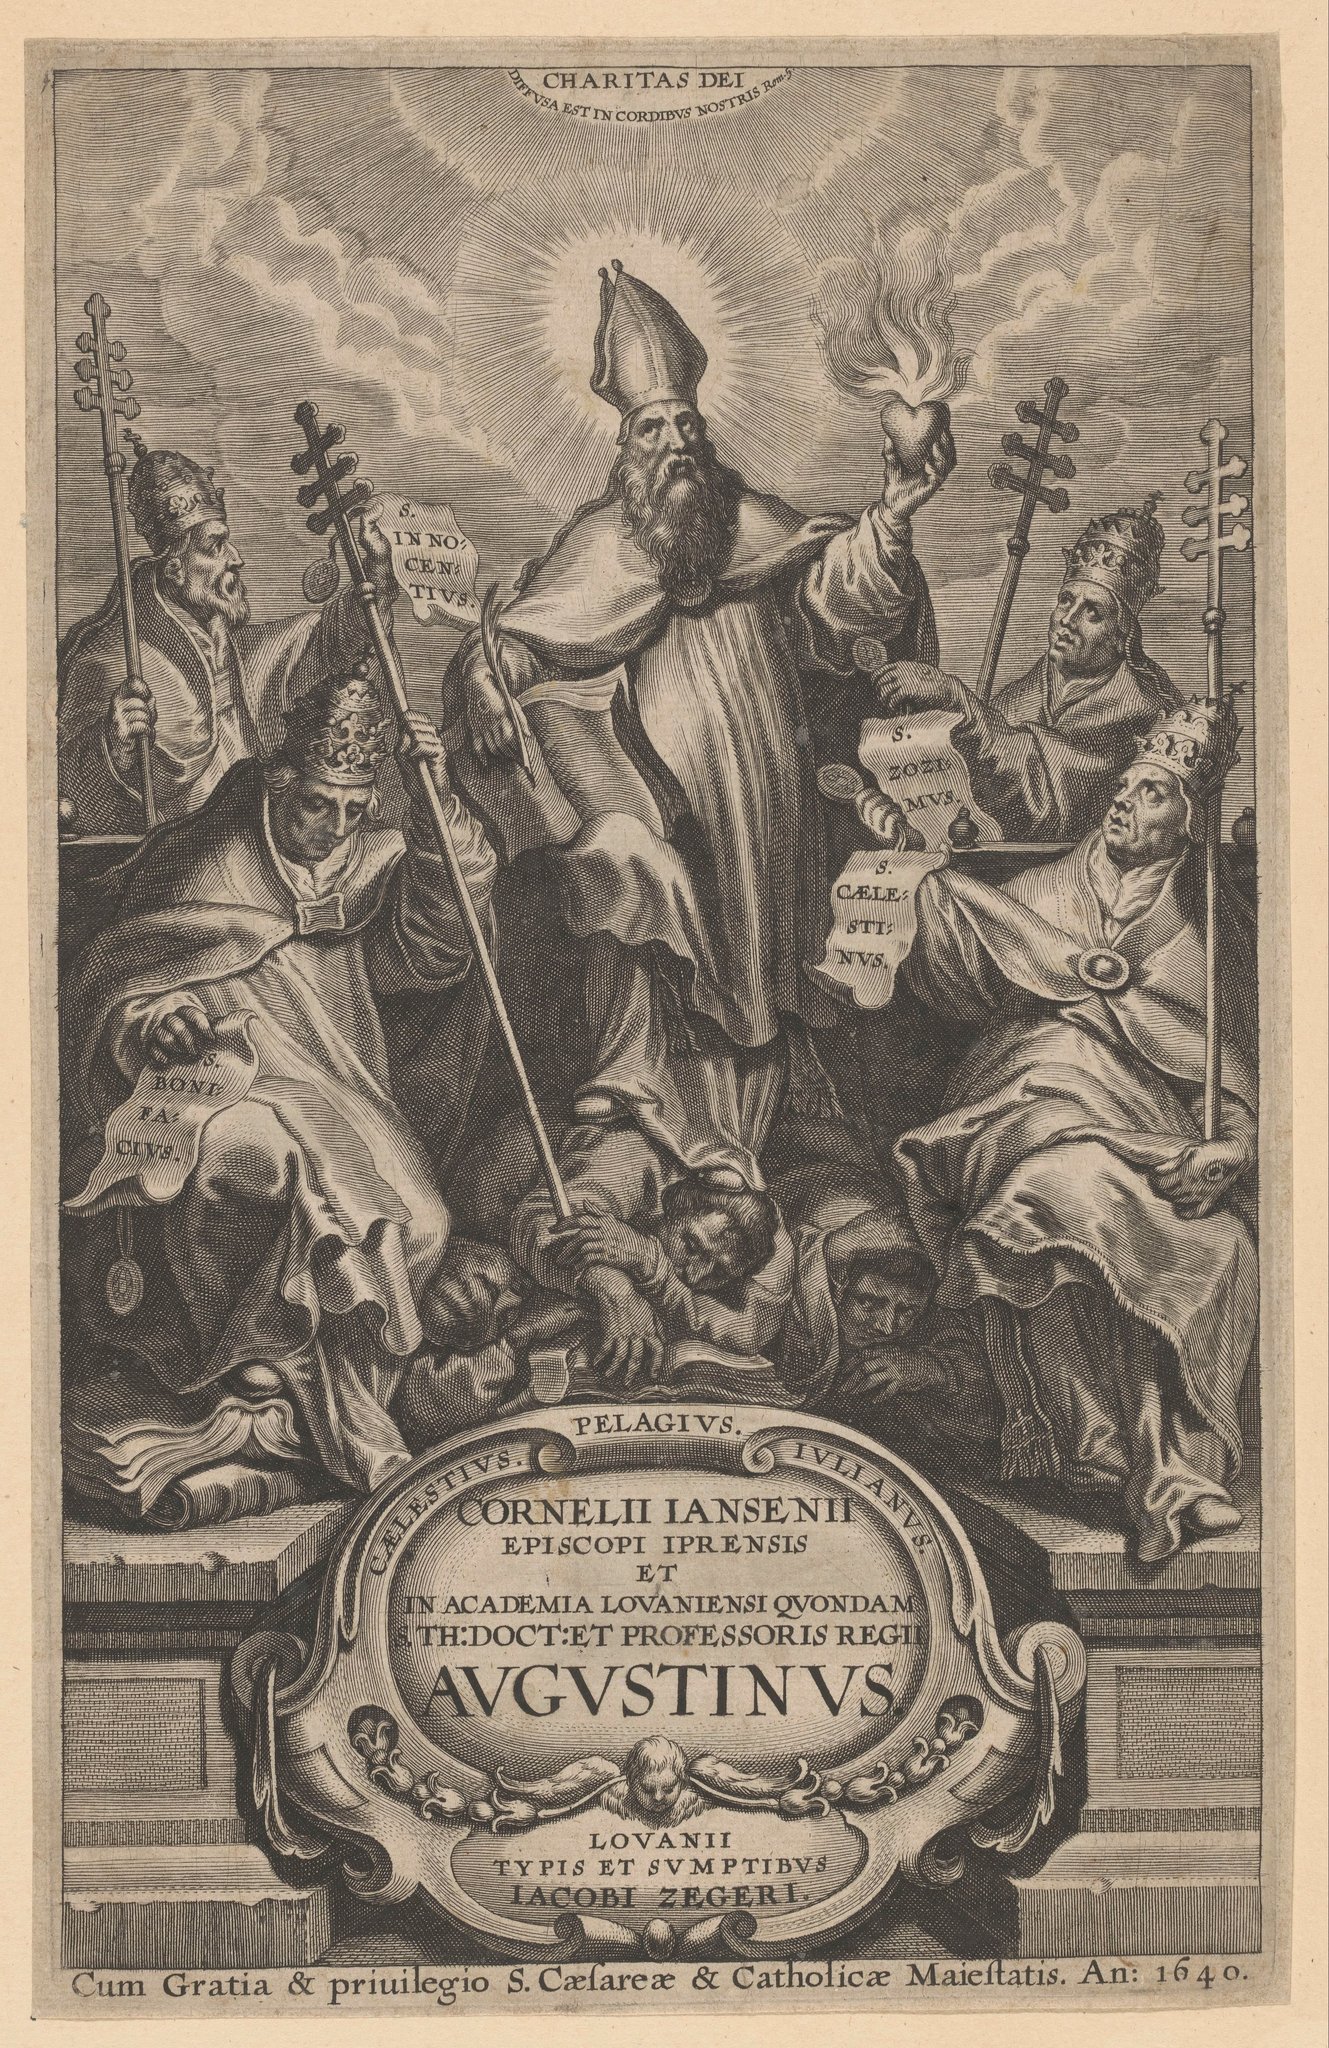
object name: titelblad, titelpagina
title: Titelpagina voor: Cornelius Jansenius, Augustinus, Leuven, 1640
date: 1640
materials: paper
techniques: engraving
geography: leuven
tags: louvain, priest, augustine, bishop of hippo; possible attributes: arrows piercing his breast, book, child with spoon, flaming heart, heart (pierced with arrows), pen, ascetical theology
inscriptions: collector's mark: Lugt 240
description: De heilige Augustinus met boek en schrijfveer toont een brandend hart. Hij draagt een bisschopsmijter. Augustinus wordt omringd door vier pausen: Innocentius, Bonifatius, Zosimus en Celestinus.